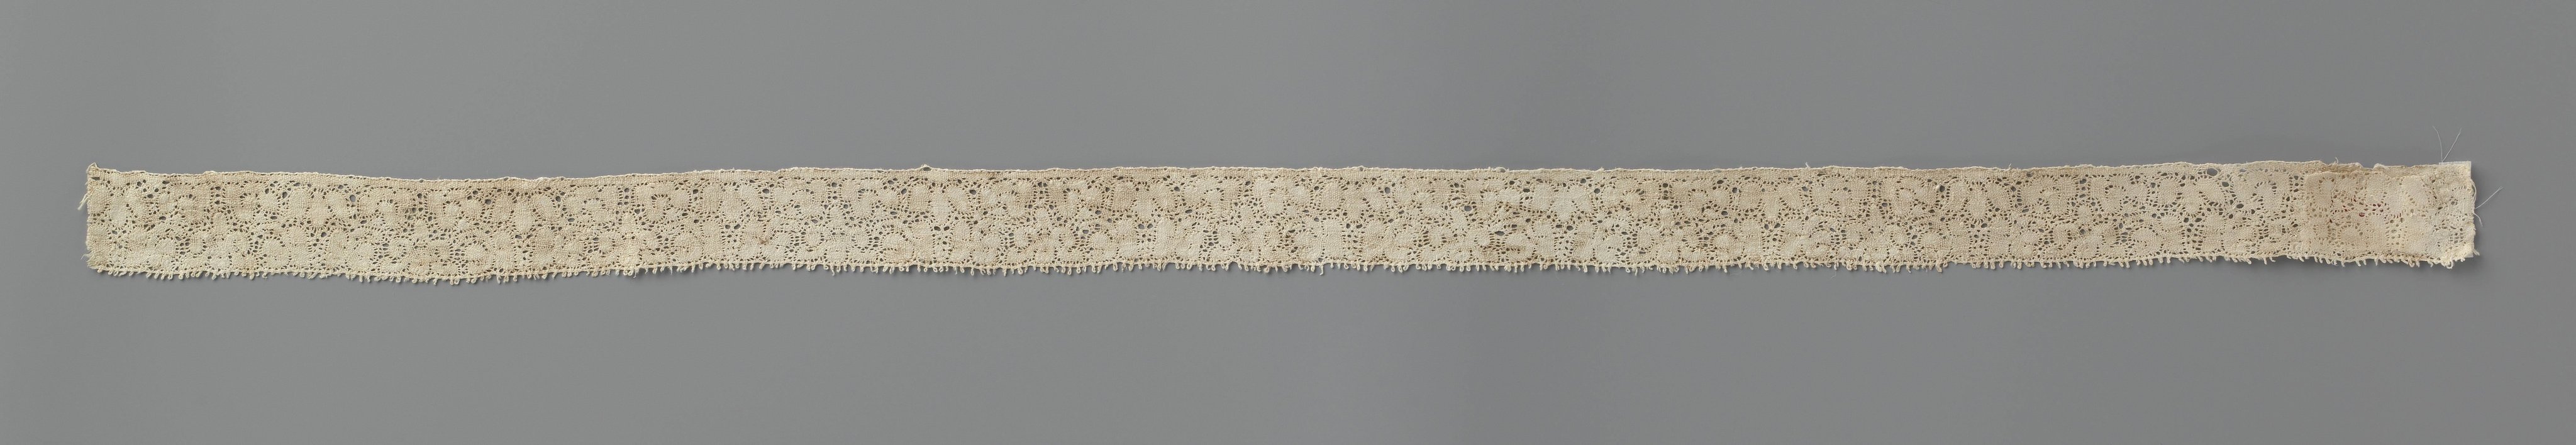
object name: strip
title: Strook kloskant met drieblad geflankeerd door rozetbloemen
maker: Anonymous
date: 1640-1660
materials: linen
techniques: lace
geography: antwerp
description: Strook naturelkleurige kloskant: oudvlaamse kant. Met kleine uitsparingen is een zich herhalend symmetrisch patroon te onderscheiden met langs de ene lange zijde een drieblad, die aan weerskanten geflankeerd wordt door een rozetbloem, en langs de andere lange zijde een gestileerde franse lelie, die aan weerskanten wordt geflankeerd door een vlindervormig blad. Er is nauwelijks sprake van een grond. De motieven zijn gemaakt in linnenslag met opengewerkte randjes. Boven- en onderzijde zijn recht afgewerkt, met langs één zijde picots.